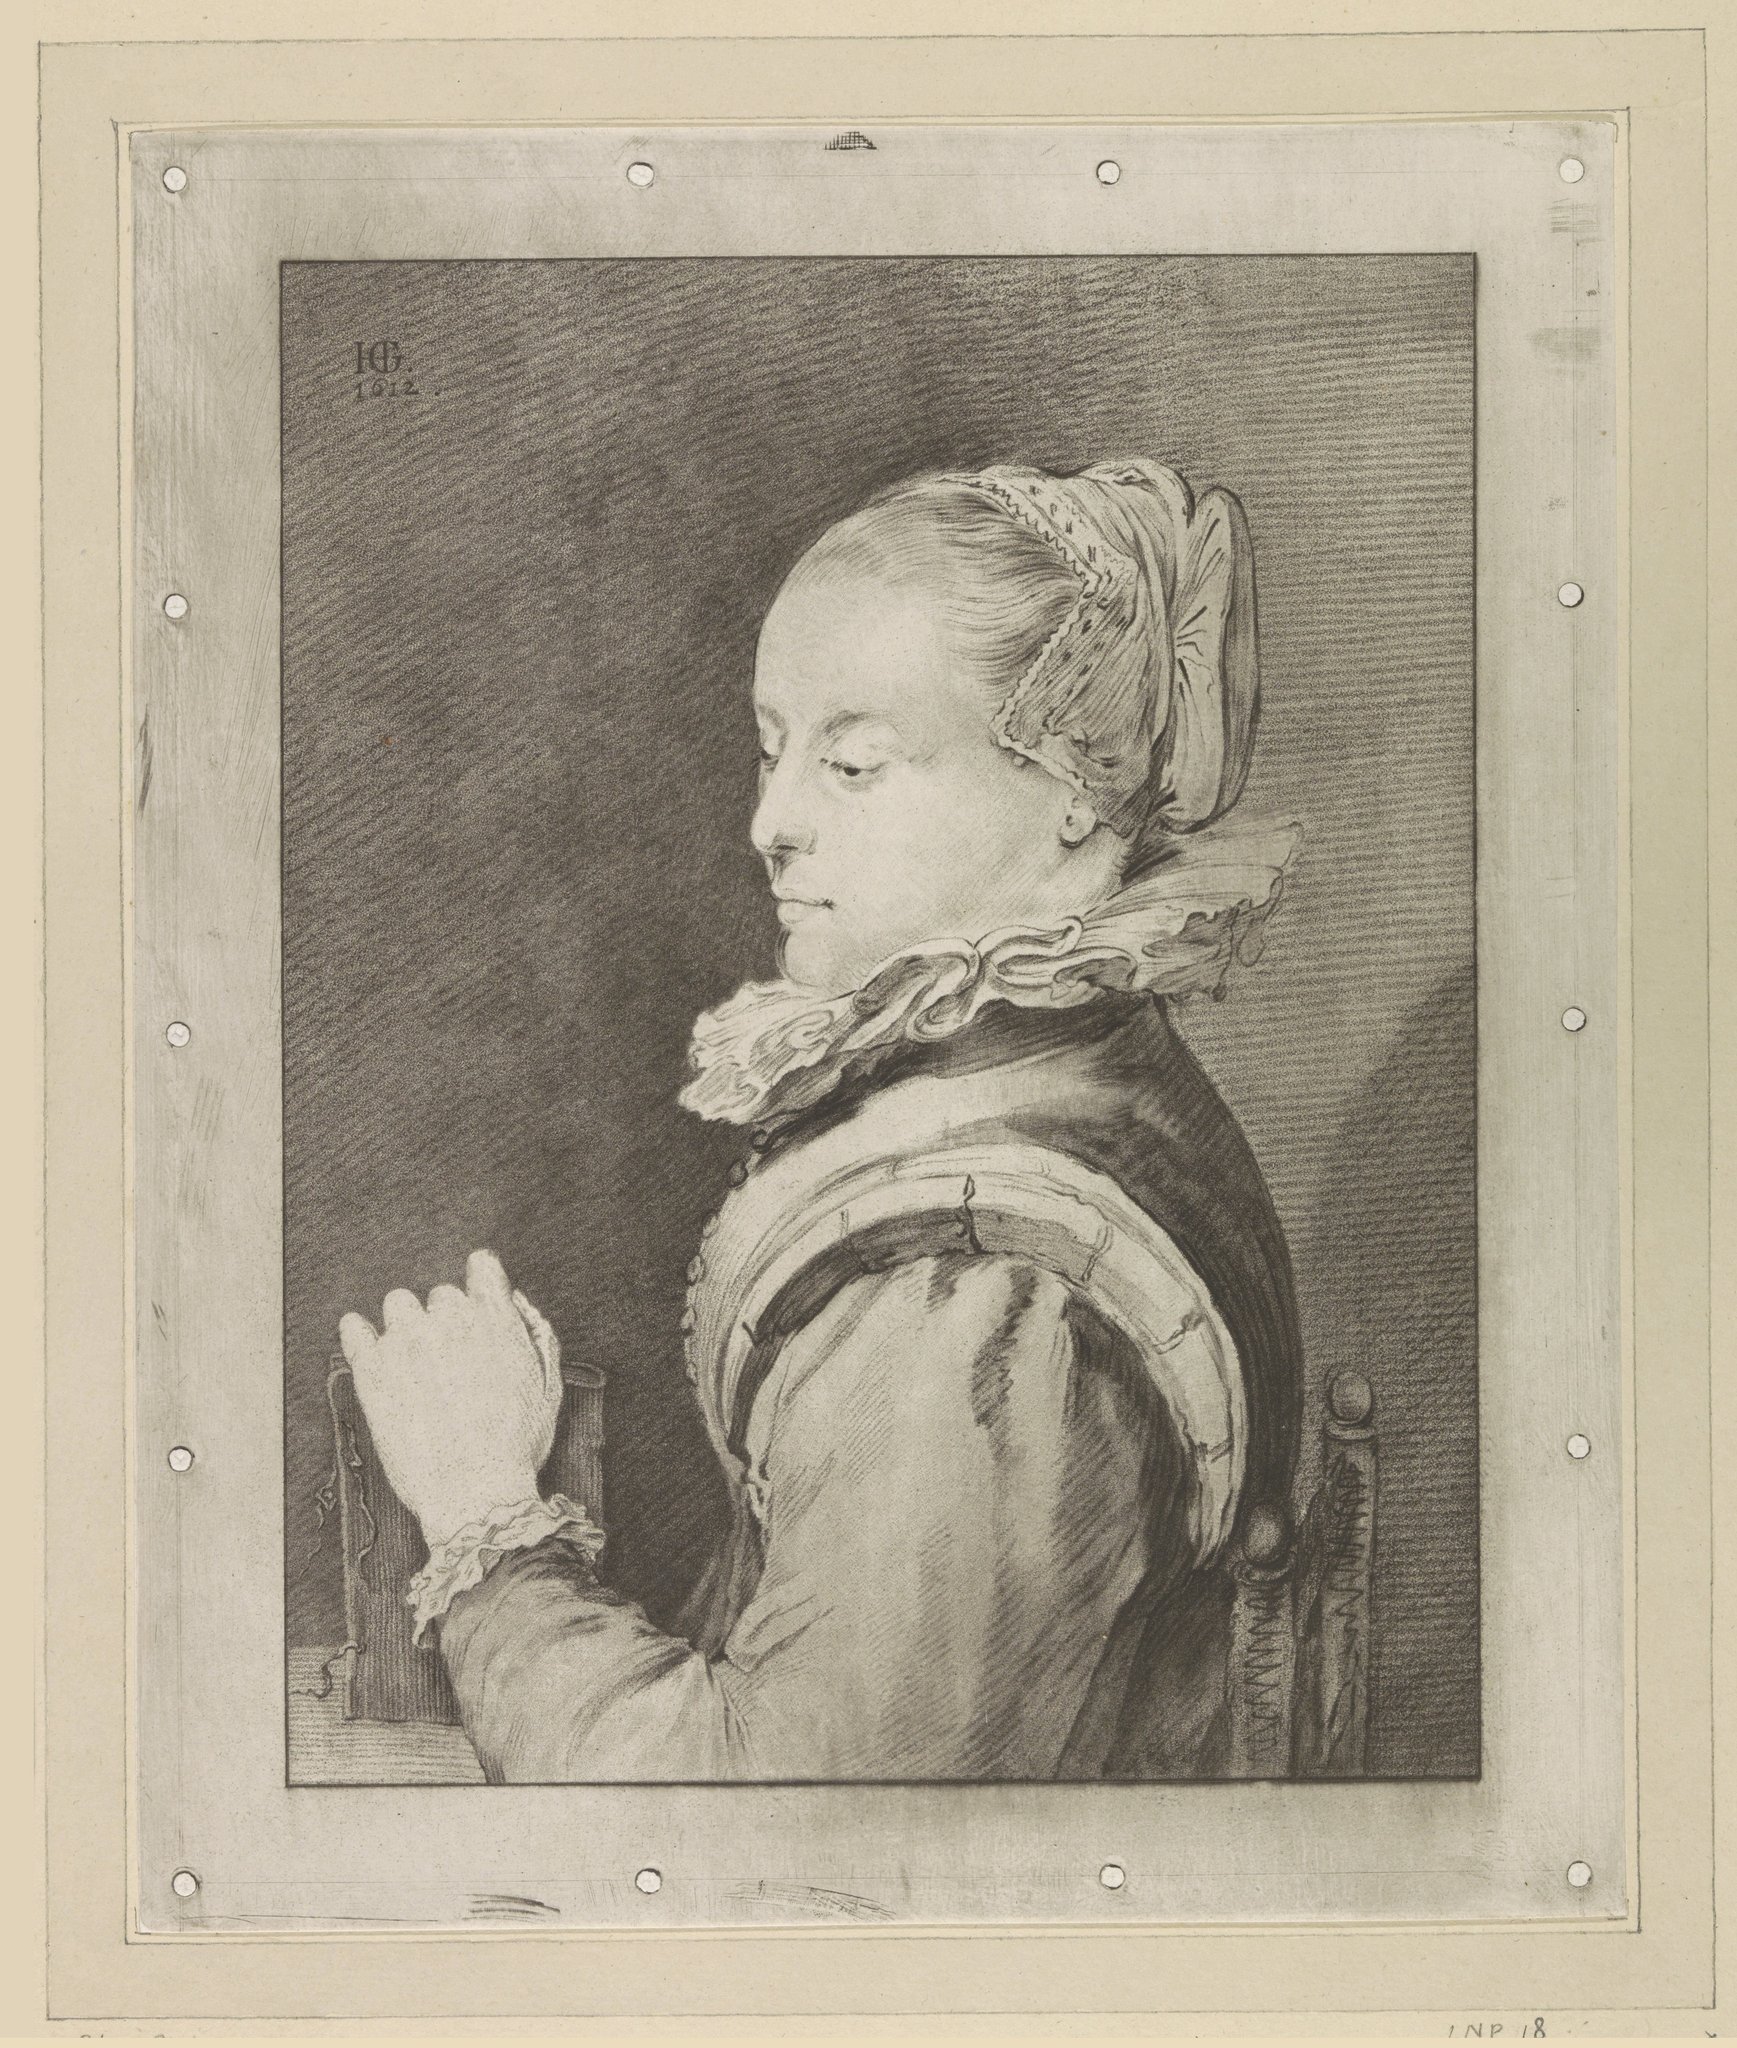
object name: print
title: Portret van Maria Tesselschade Roemers Visscher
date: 1770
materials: paper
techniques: printmaking, etching, roulette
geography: amsterdam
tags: amsterdam, maria tesselschade roemers visscher, adult woman, book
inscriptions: collector's mark: Lugt 2228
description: Naar een tekening van Hendrick Goltzius in het Amsterdam Museum. Vanaf de achttiende eeuw werd de geportretteerde, onder andere door Cornelis Ploos van Amstel, regelmatig aangeduid als zijnde Maria Tesselschade Roemer Visscher, maar dat is onjuist gebleken.